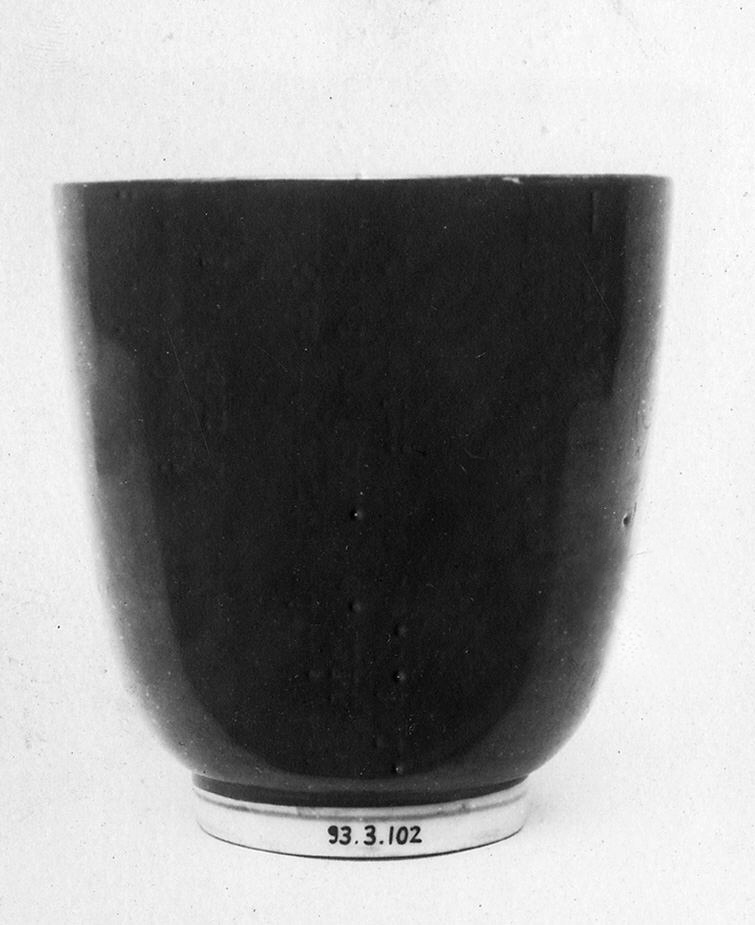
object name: cup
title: Deep Cup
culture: japanese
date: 1800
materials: glaze, porcelain